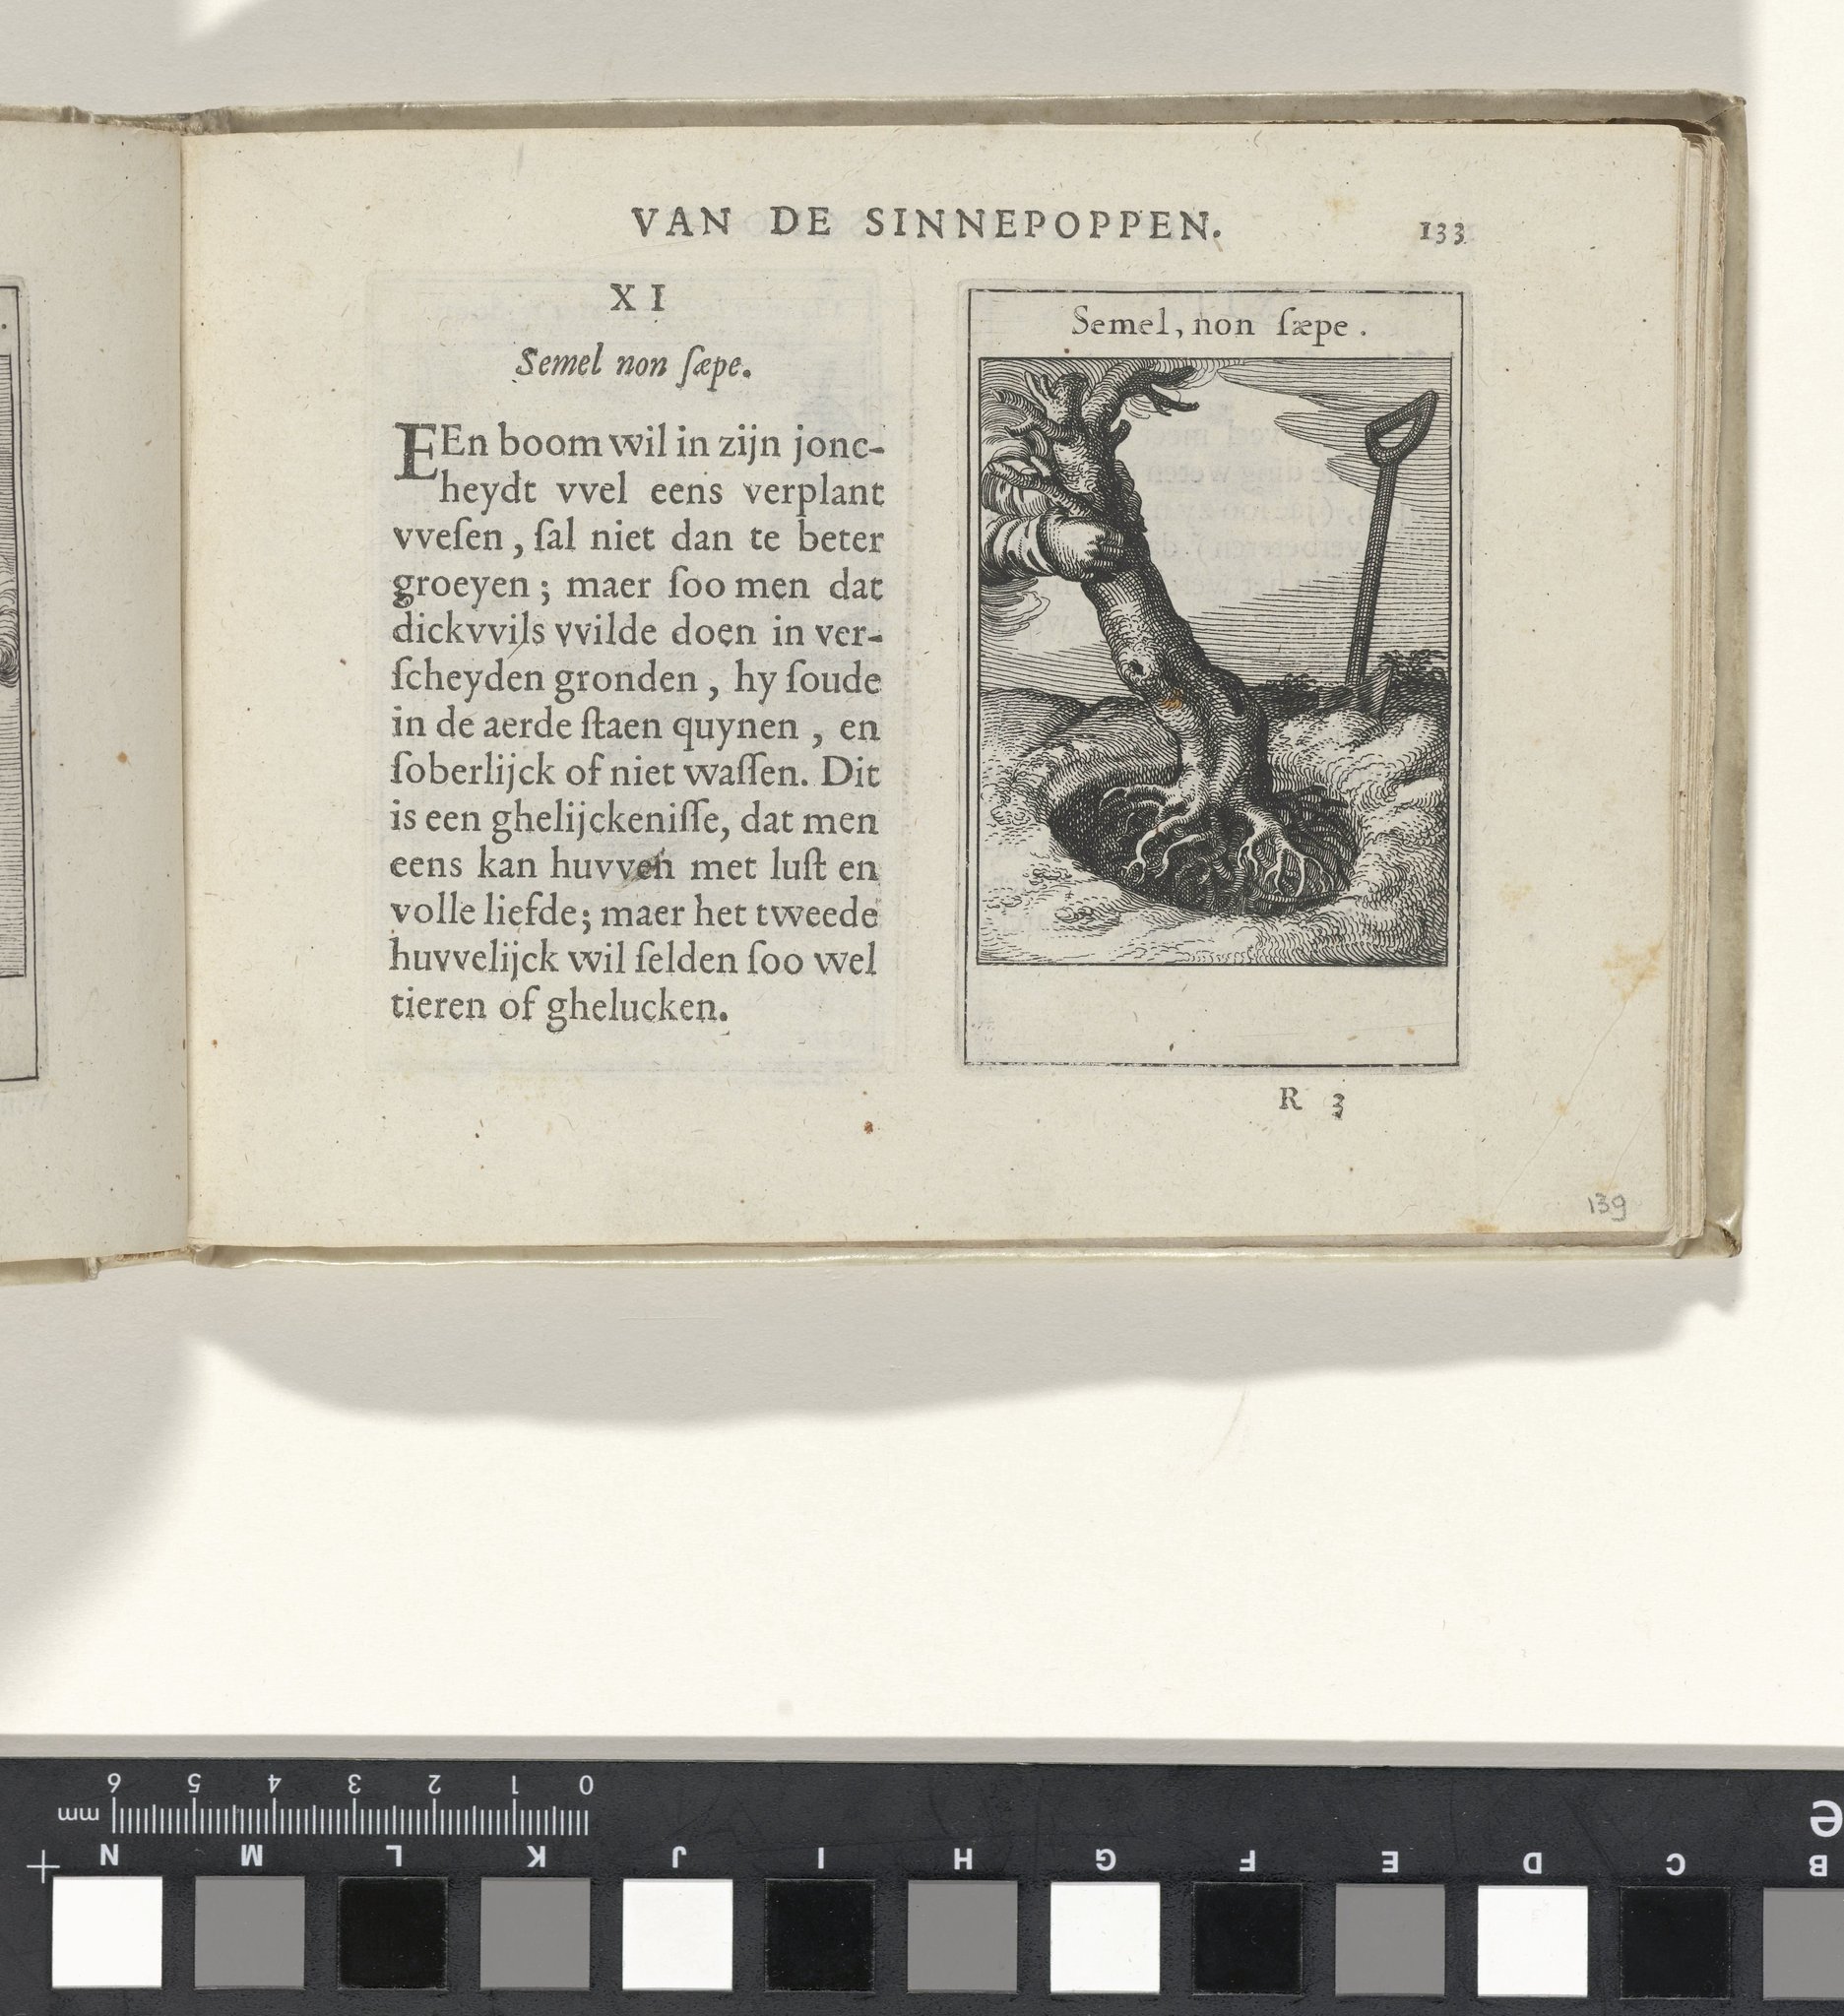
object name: album leaf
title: XI Semel, non saepe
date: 1614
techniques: engraving, printing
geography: amsterdam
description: XI Semel, non saepe. Derde schok. Onderdeel van 'Sinnepoppen', R. Visscher, 1614.